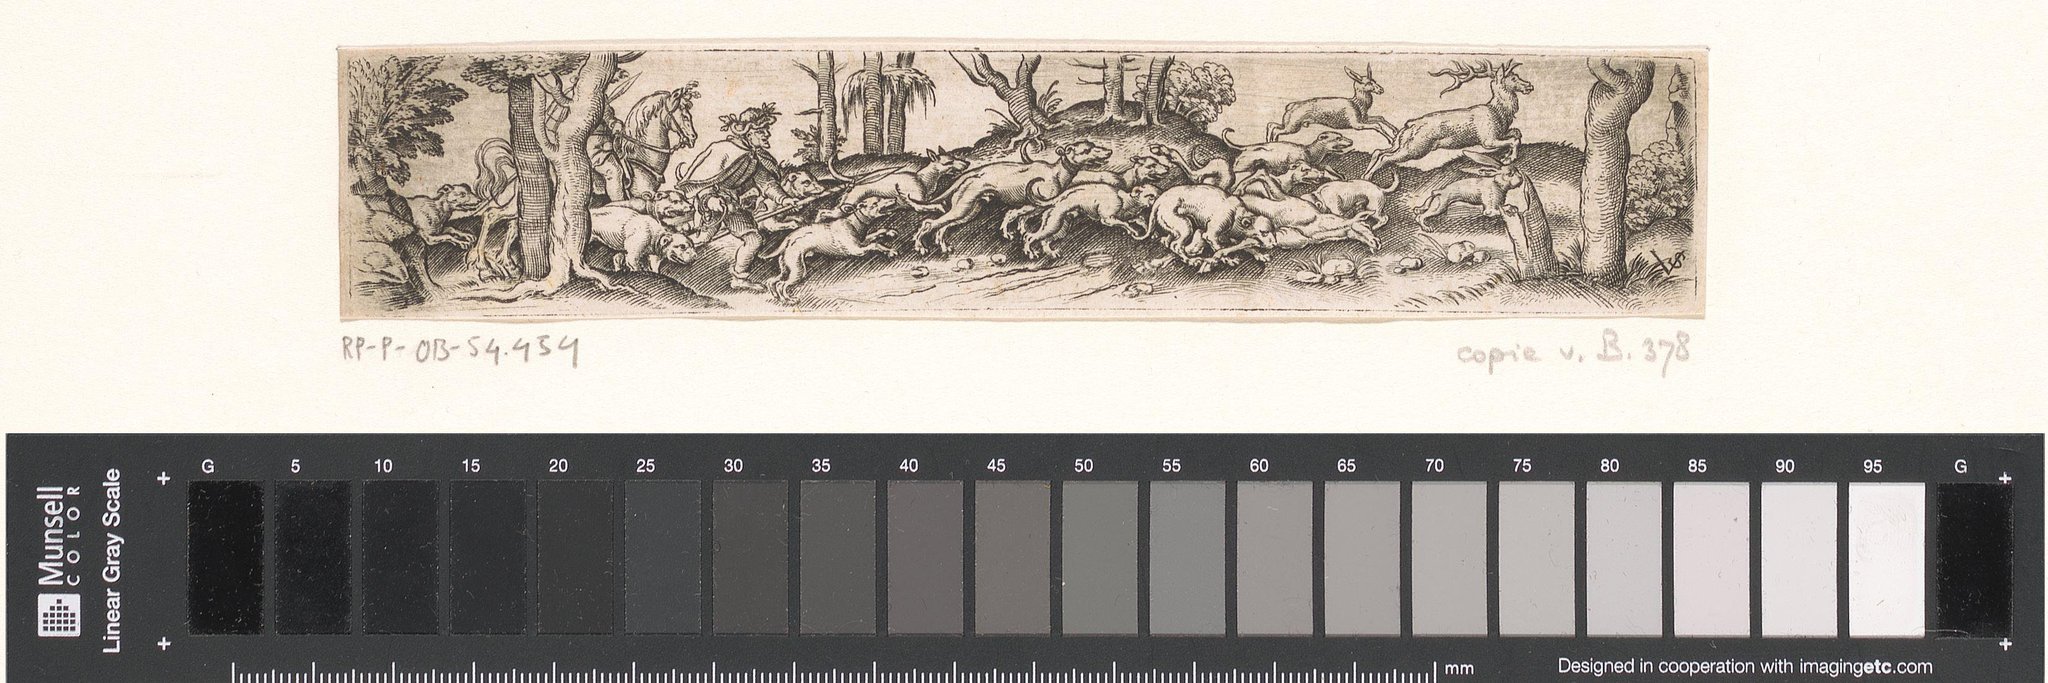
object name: print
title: Hertenjacht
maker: virgilius solis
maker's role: draughtsman, print maker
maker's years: 1514-1562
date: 1524-1562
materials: paper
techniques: engraving, etching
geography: nuremberg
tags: riding a horse, ass, or mule; rider, horseman, stag-hunting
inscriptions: number: ‘28’, collector's mark: Lugt 2228